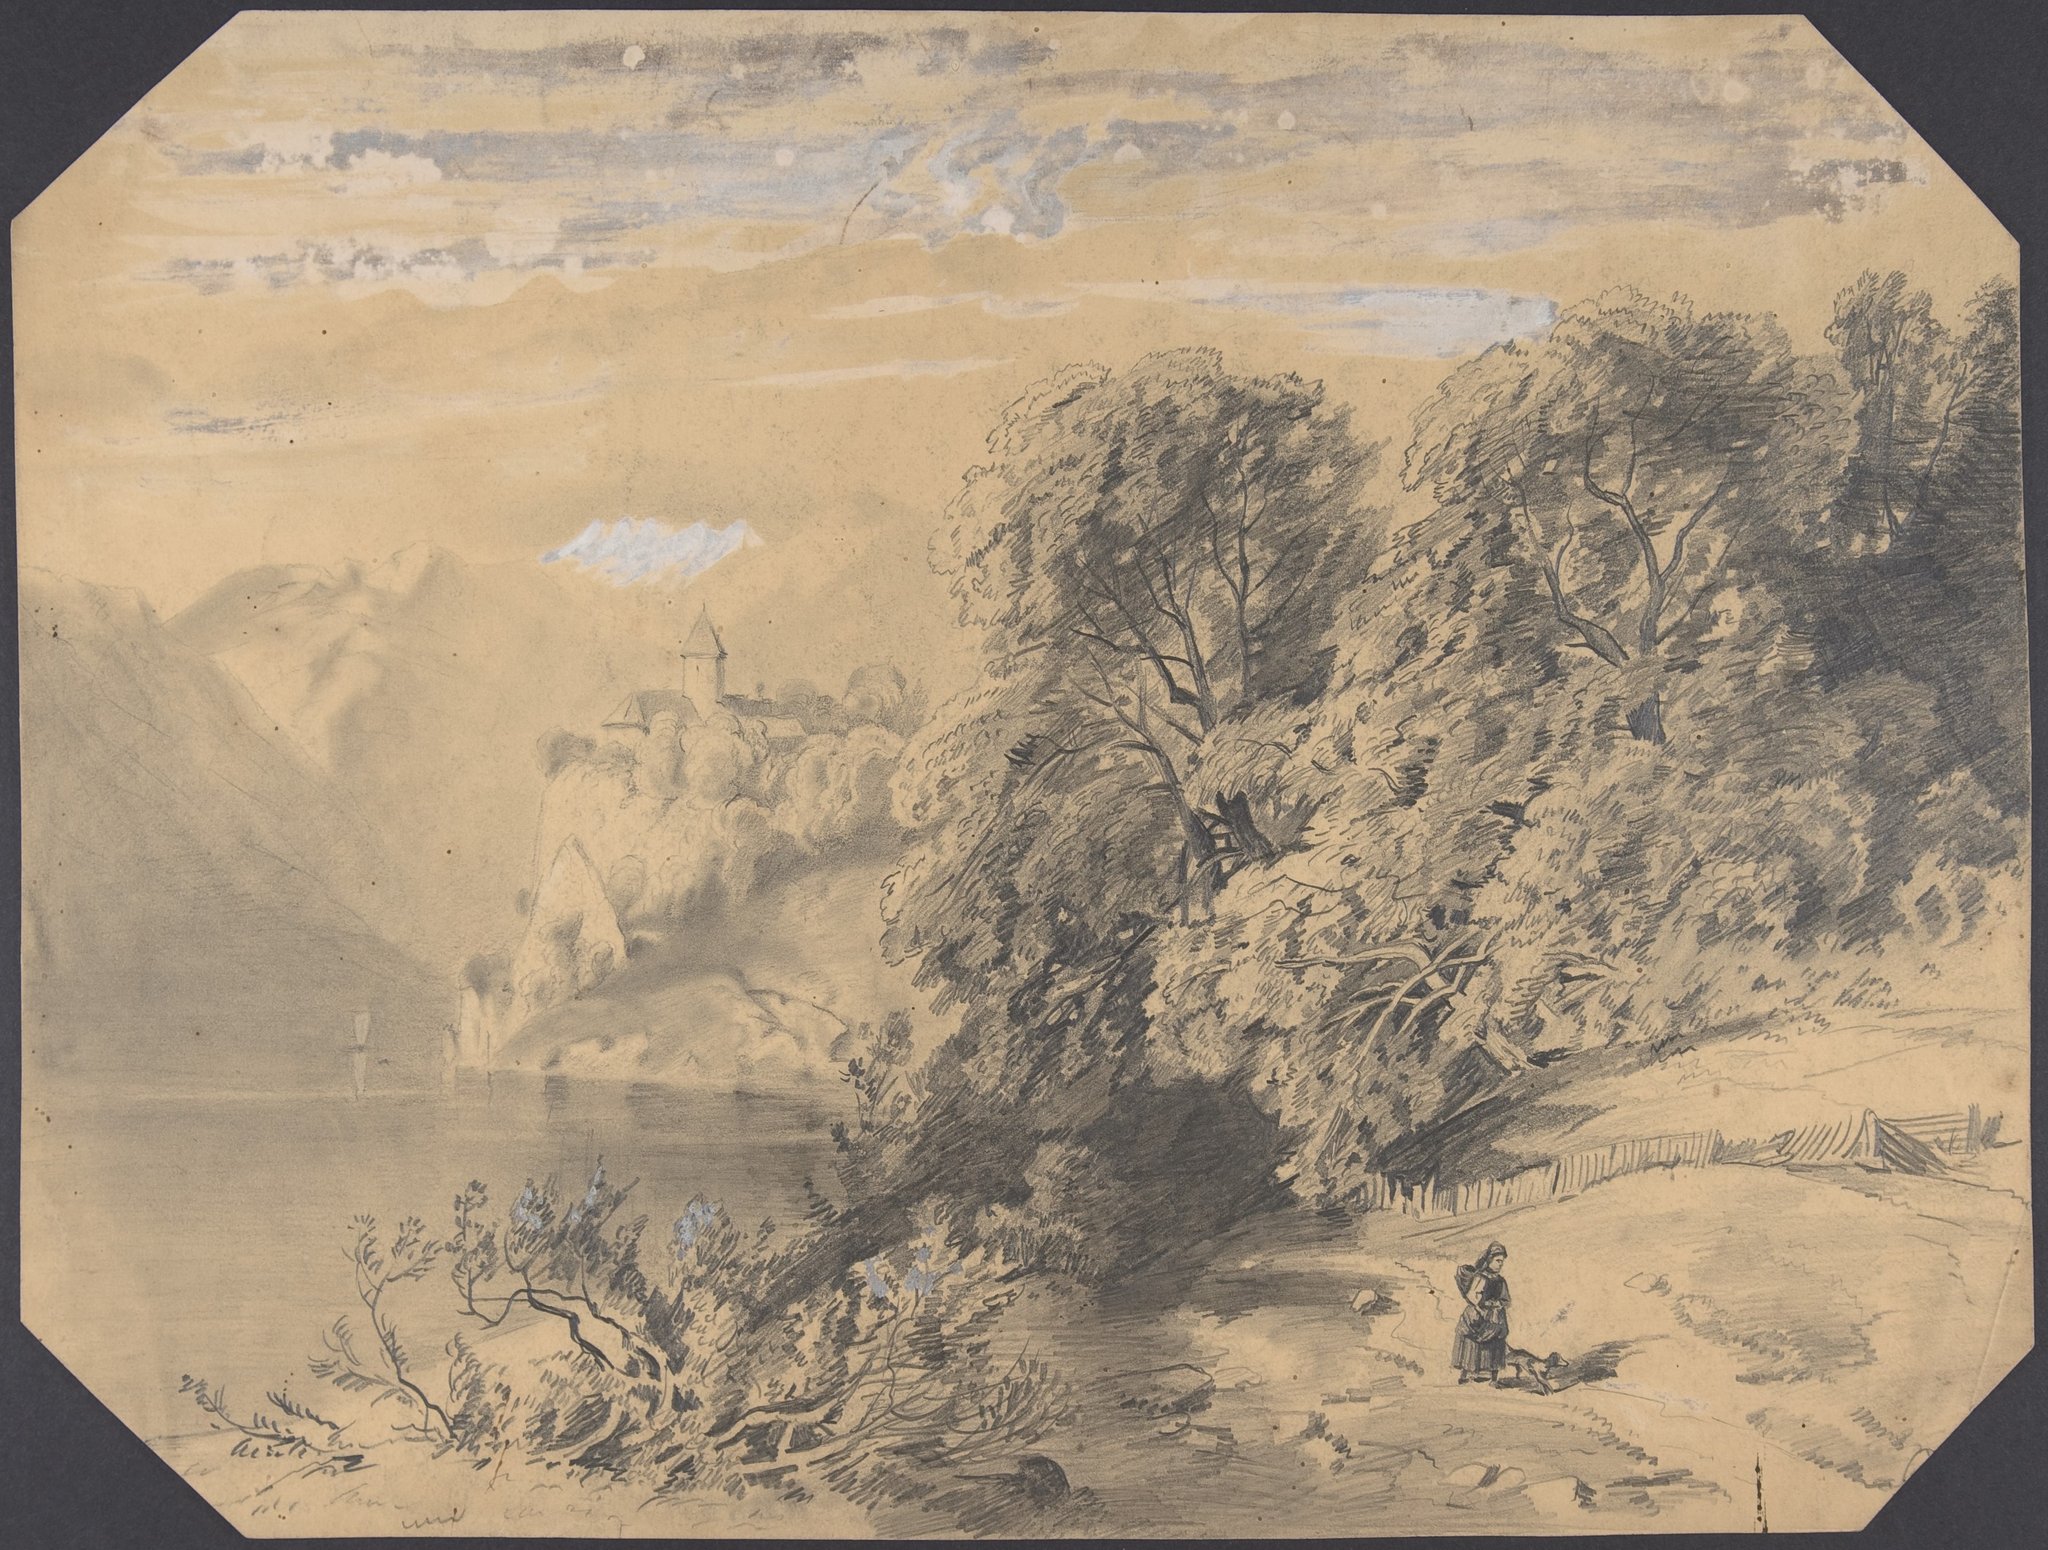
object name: drawing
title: Woman with a dog by a mountain lake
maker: alexandre calame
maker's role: artist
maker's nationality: swiss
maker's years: 1810-1864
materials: paint, graphite, paper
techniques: cutting, heightening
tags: women,dogs,lakes,mountains,trees